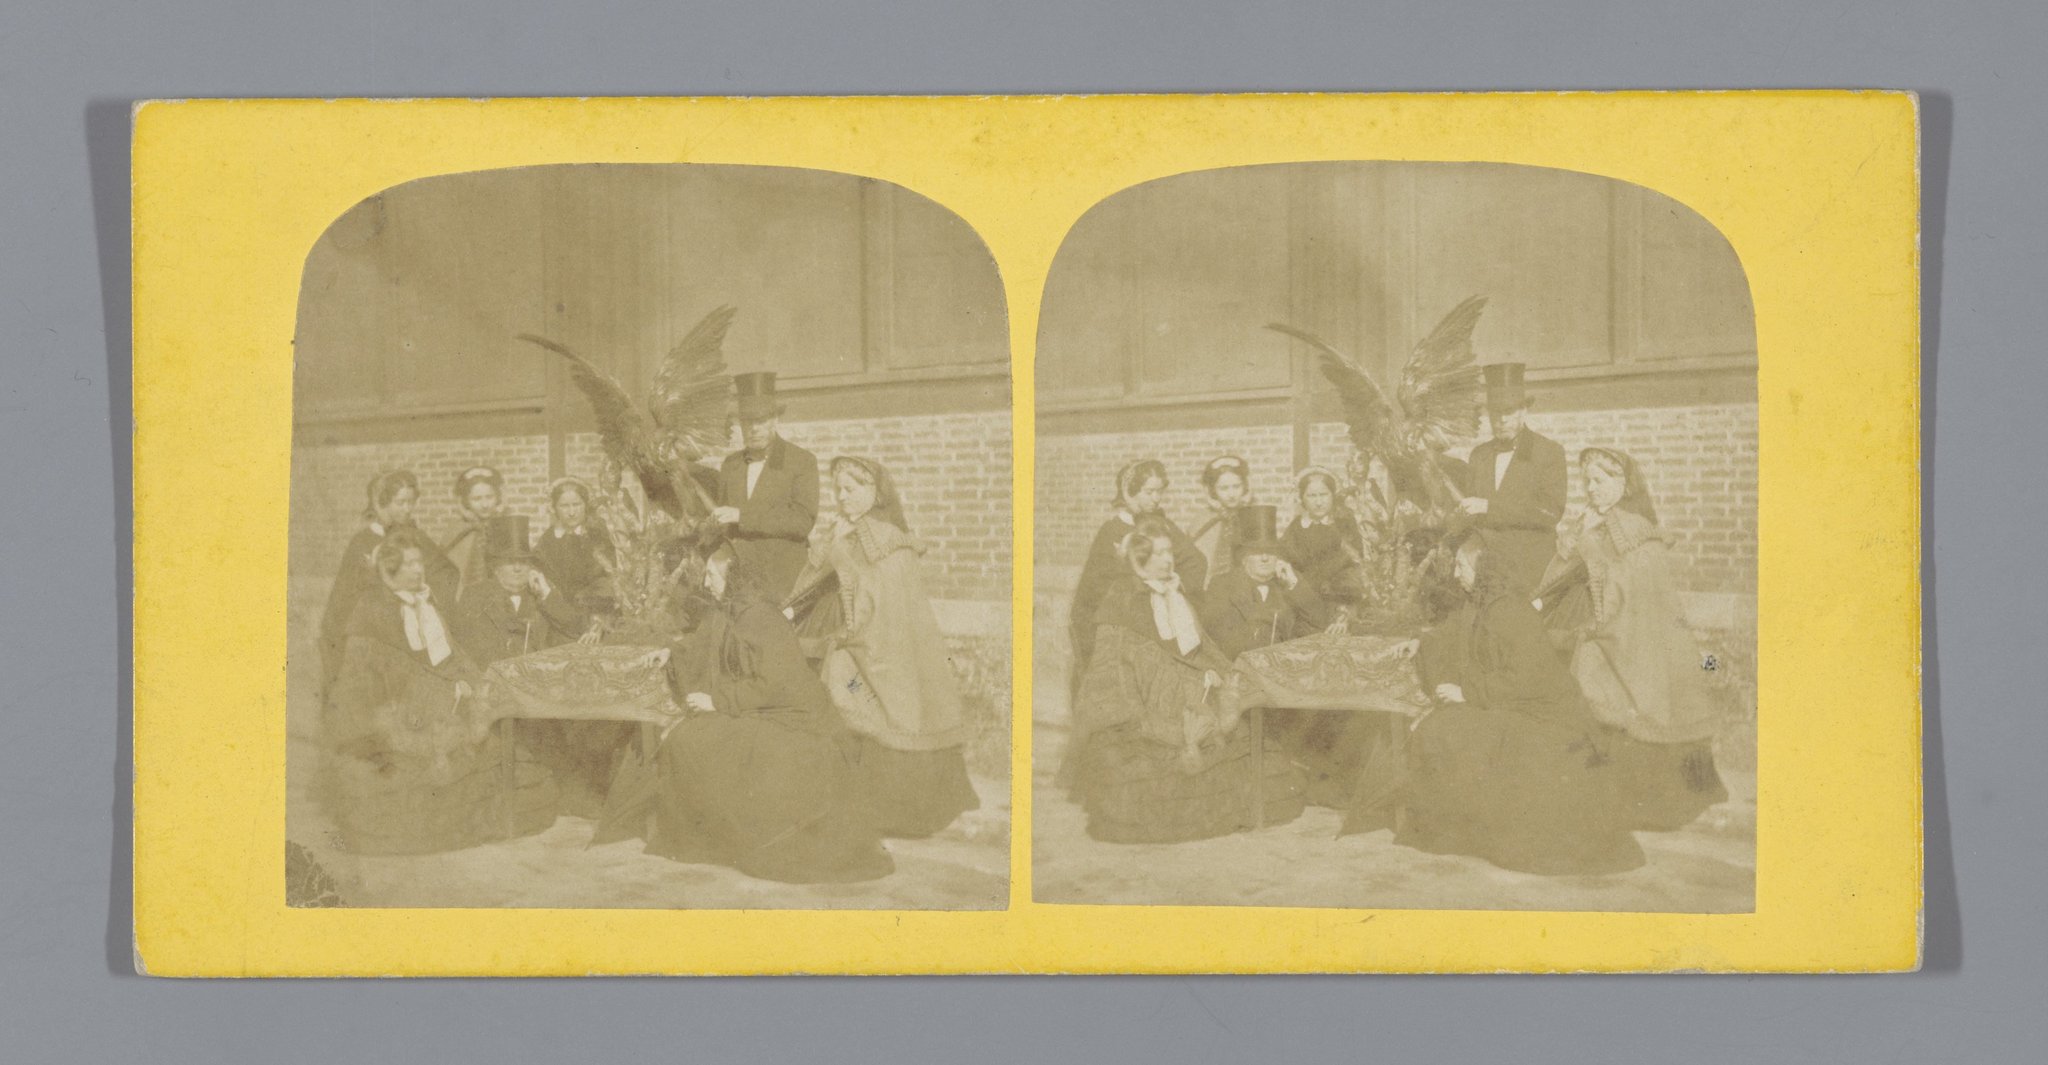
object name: stereograph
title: Gezelschap rond een buitentafel met daarop een vogel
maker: Anonymous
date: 1850-1880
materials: cardboard, photographic support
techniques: albumen print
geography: europe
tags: predatory birds, head-gear: top hat, europe